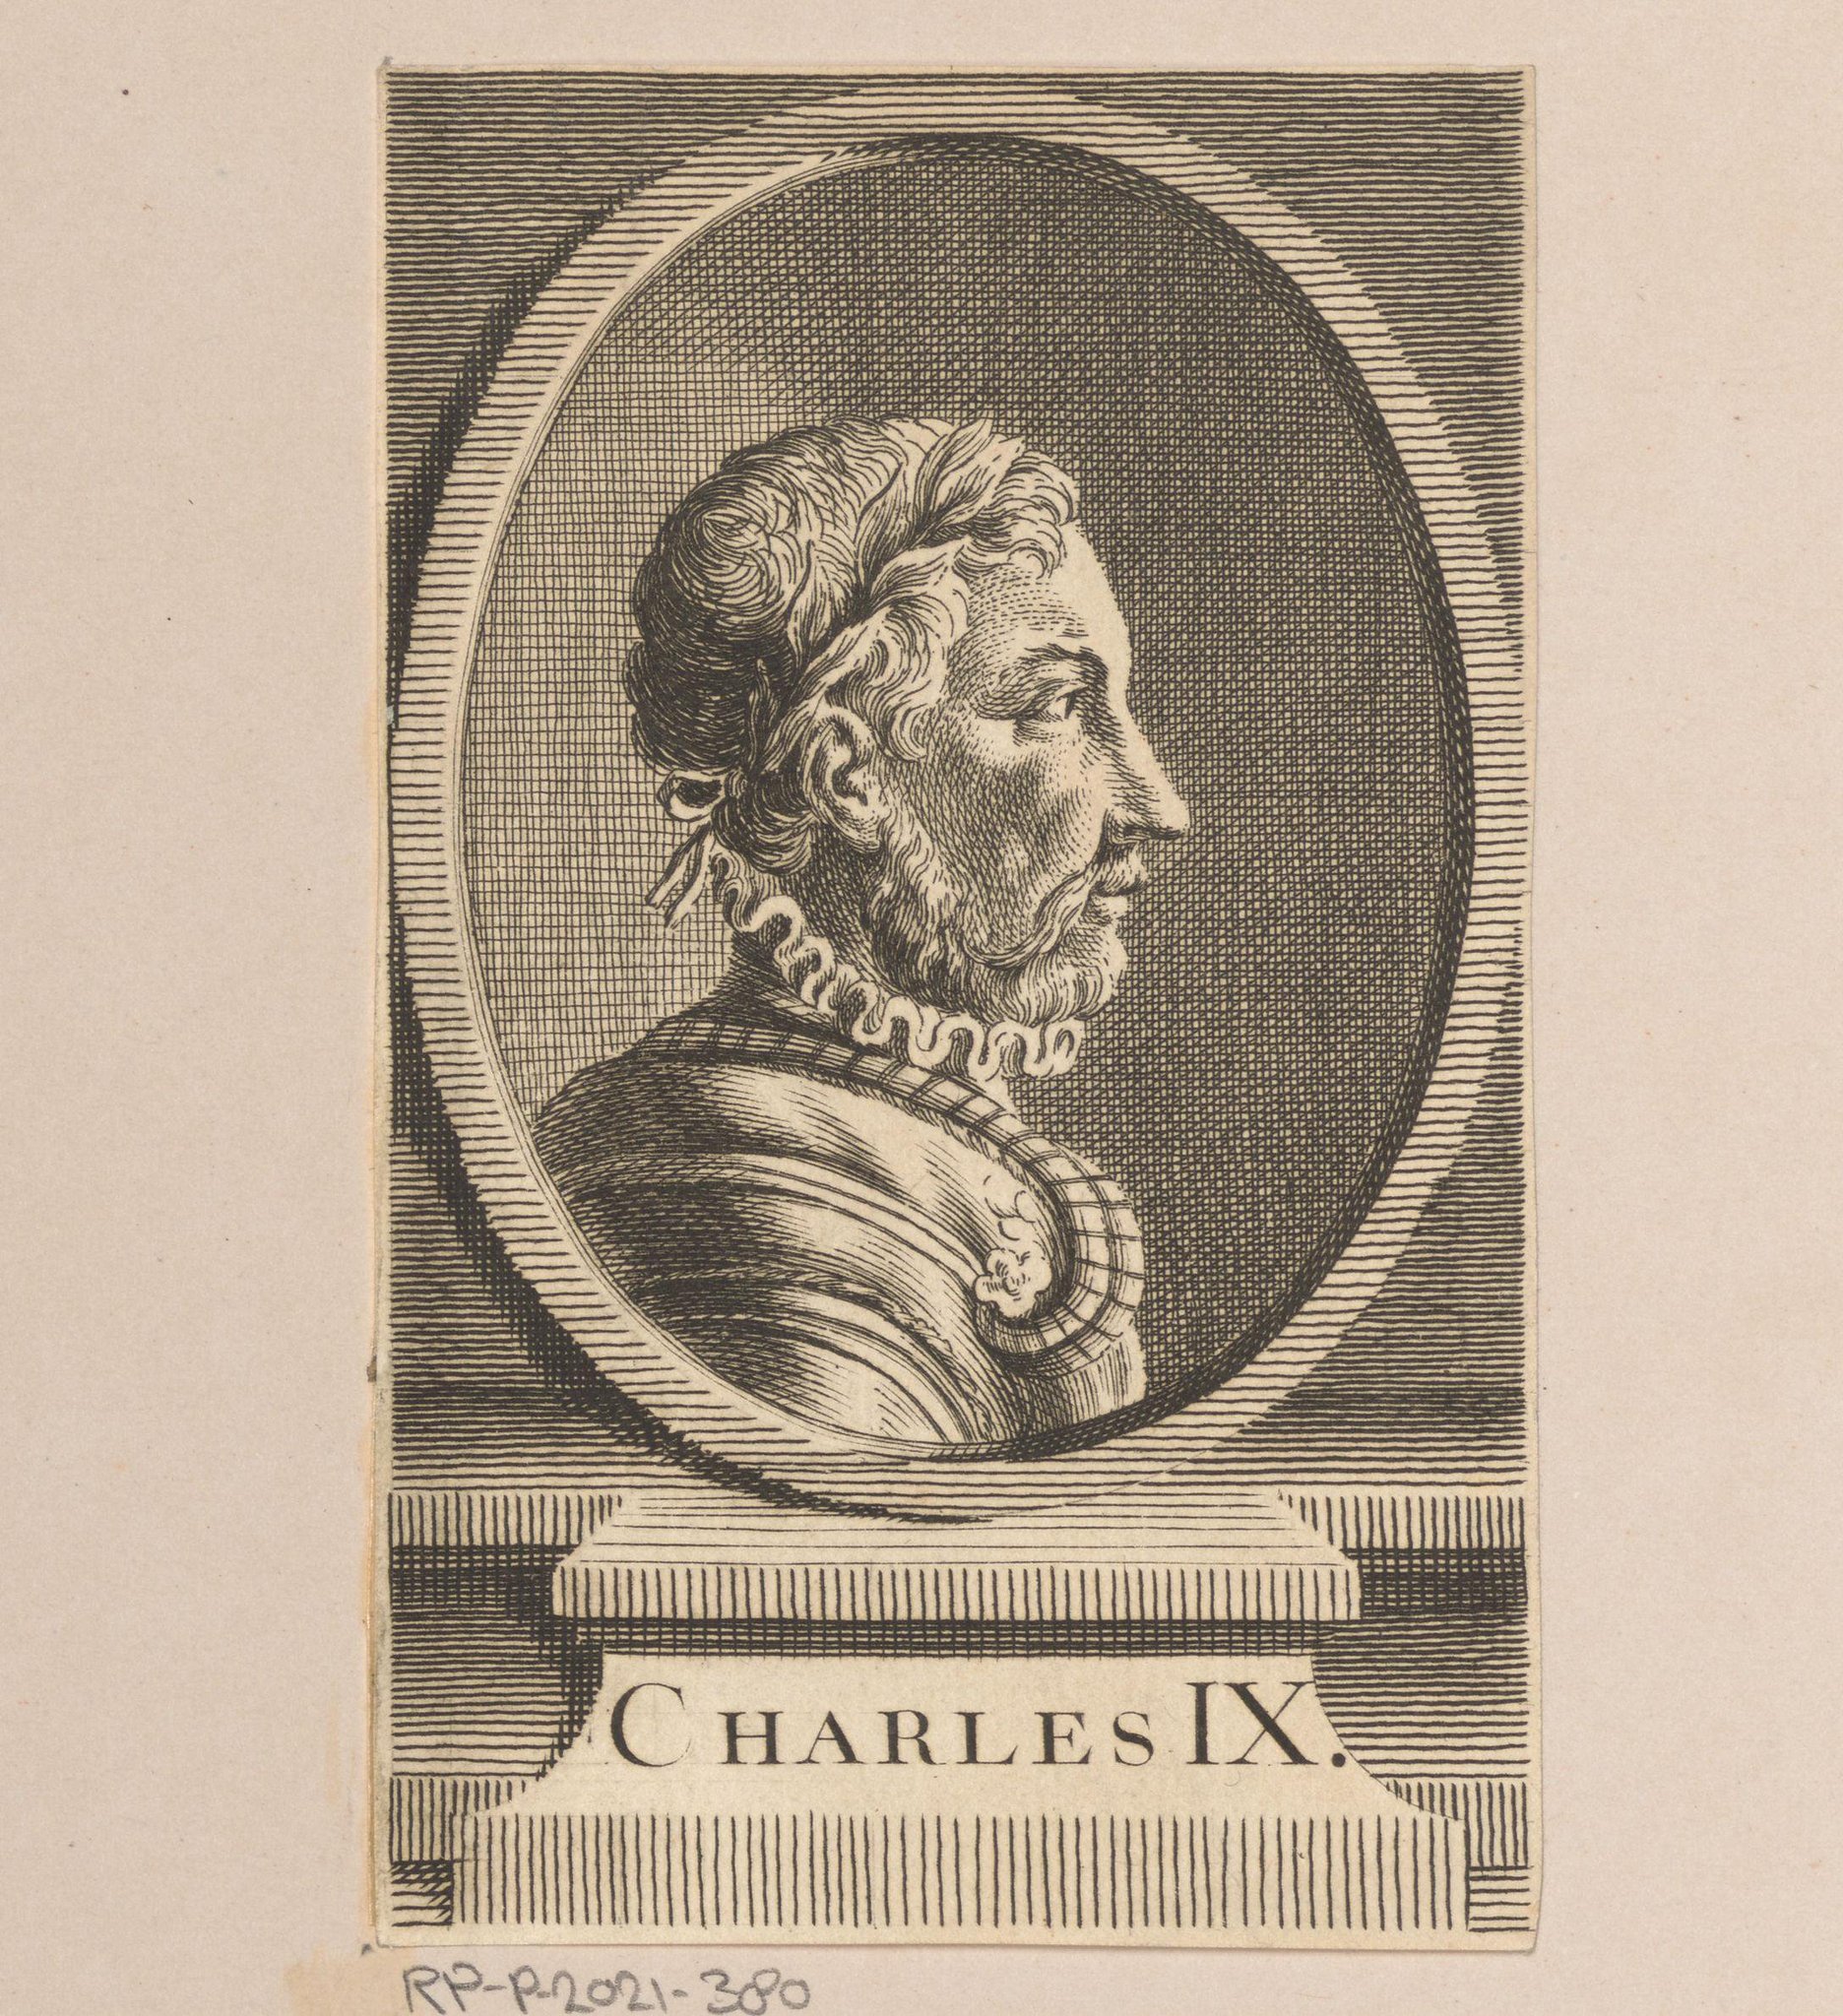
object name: print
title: Portret van Karel IX, koning van Frankrijk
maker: Anonymous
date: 1700-1799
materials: paper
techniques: engraving, etching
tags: karel ix (koning van frankrijk), historical persons, king